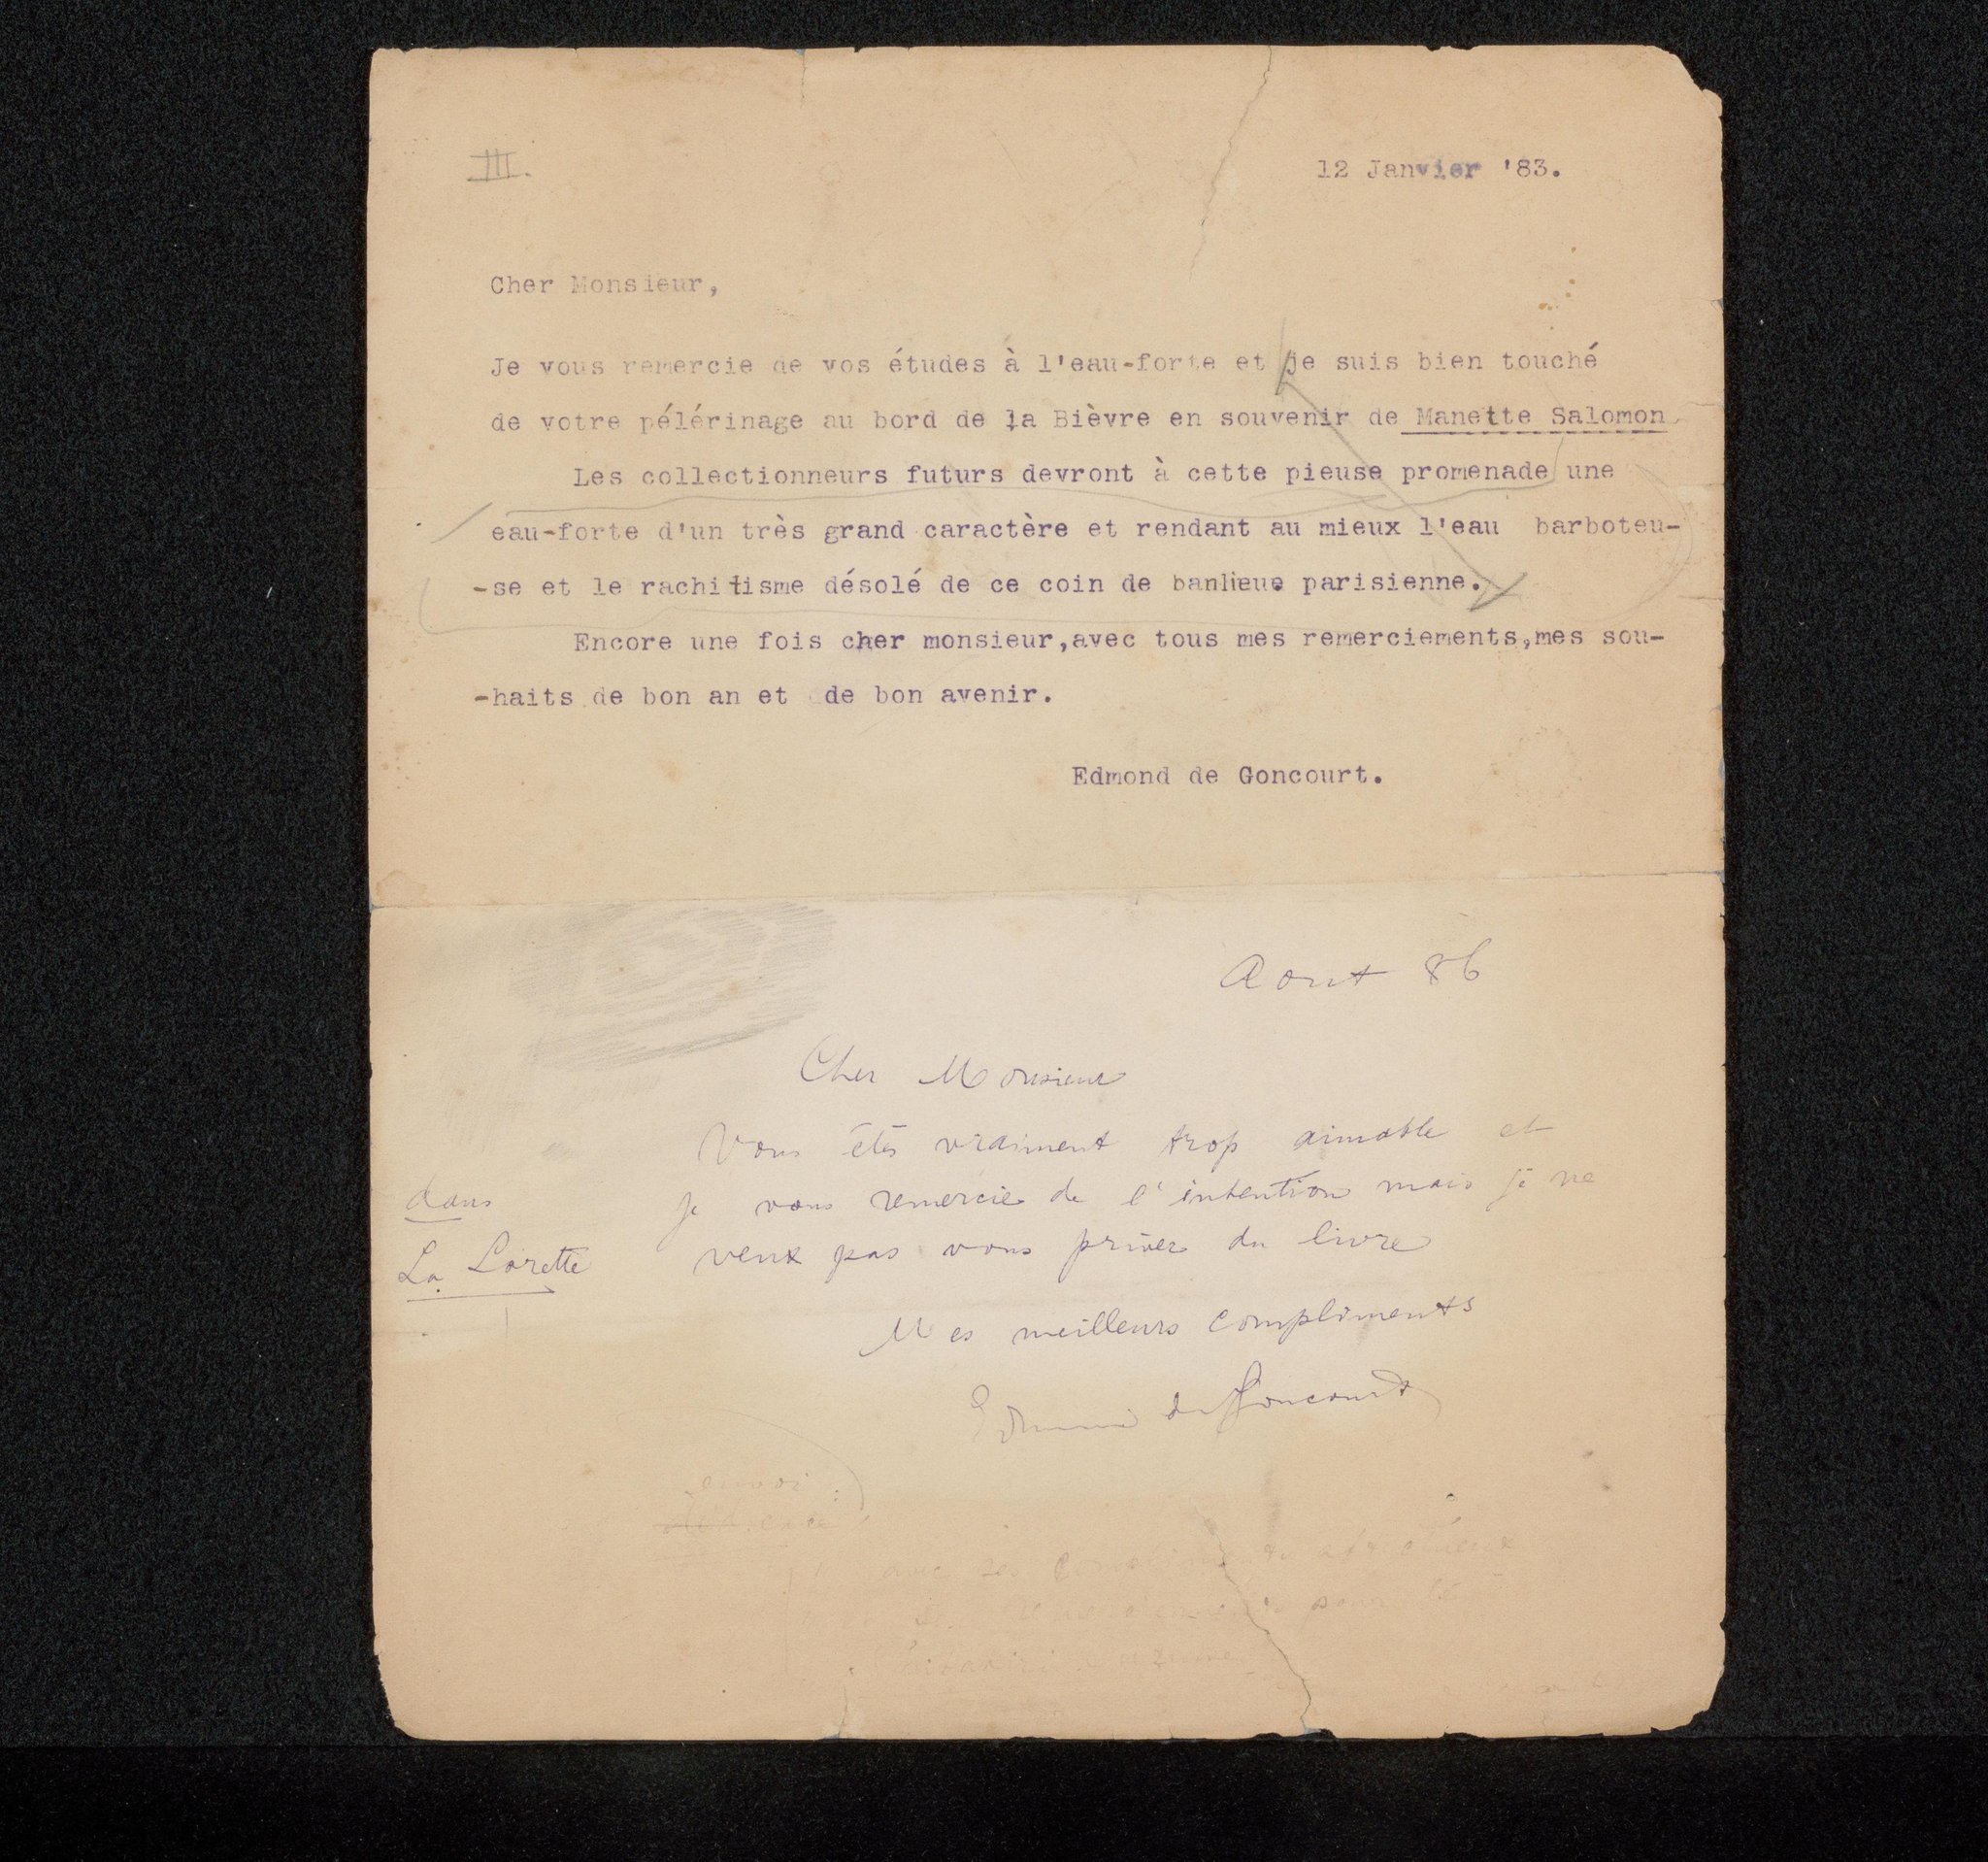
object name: letter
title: Brief aan Philip Zilcken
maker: edmond de goncourt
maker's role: draughtsman, painter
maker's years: 1822-1896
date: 1808-1886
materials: ink, paper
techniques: pen, typewriting, writing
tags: the hague, philip zilcken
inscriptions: collector's mark: ‘RPK’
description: Brief geschreven op transcriptie van RP-D-1982-43-GONCOURT(EDMONDDE)-3A.